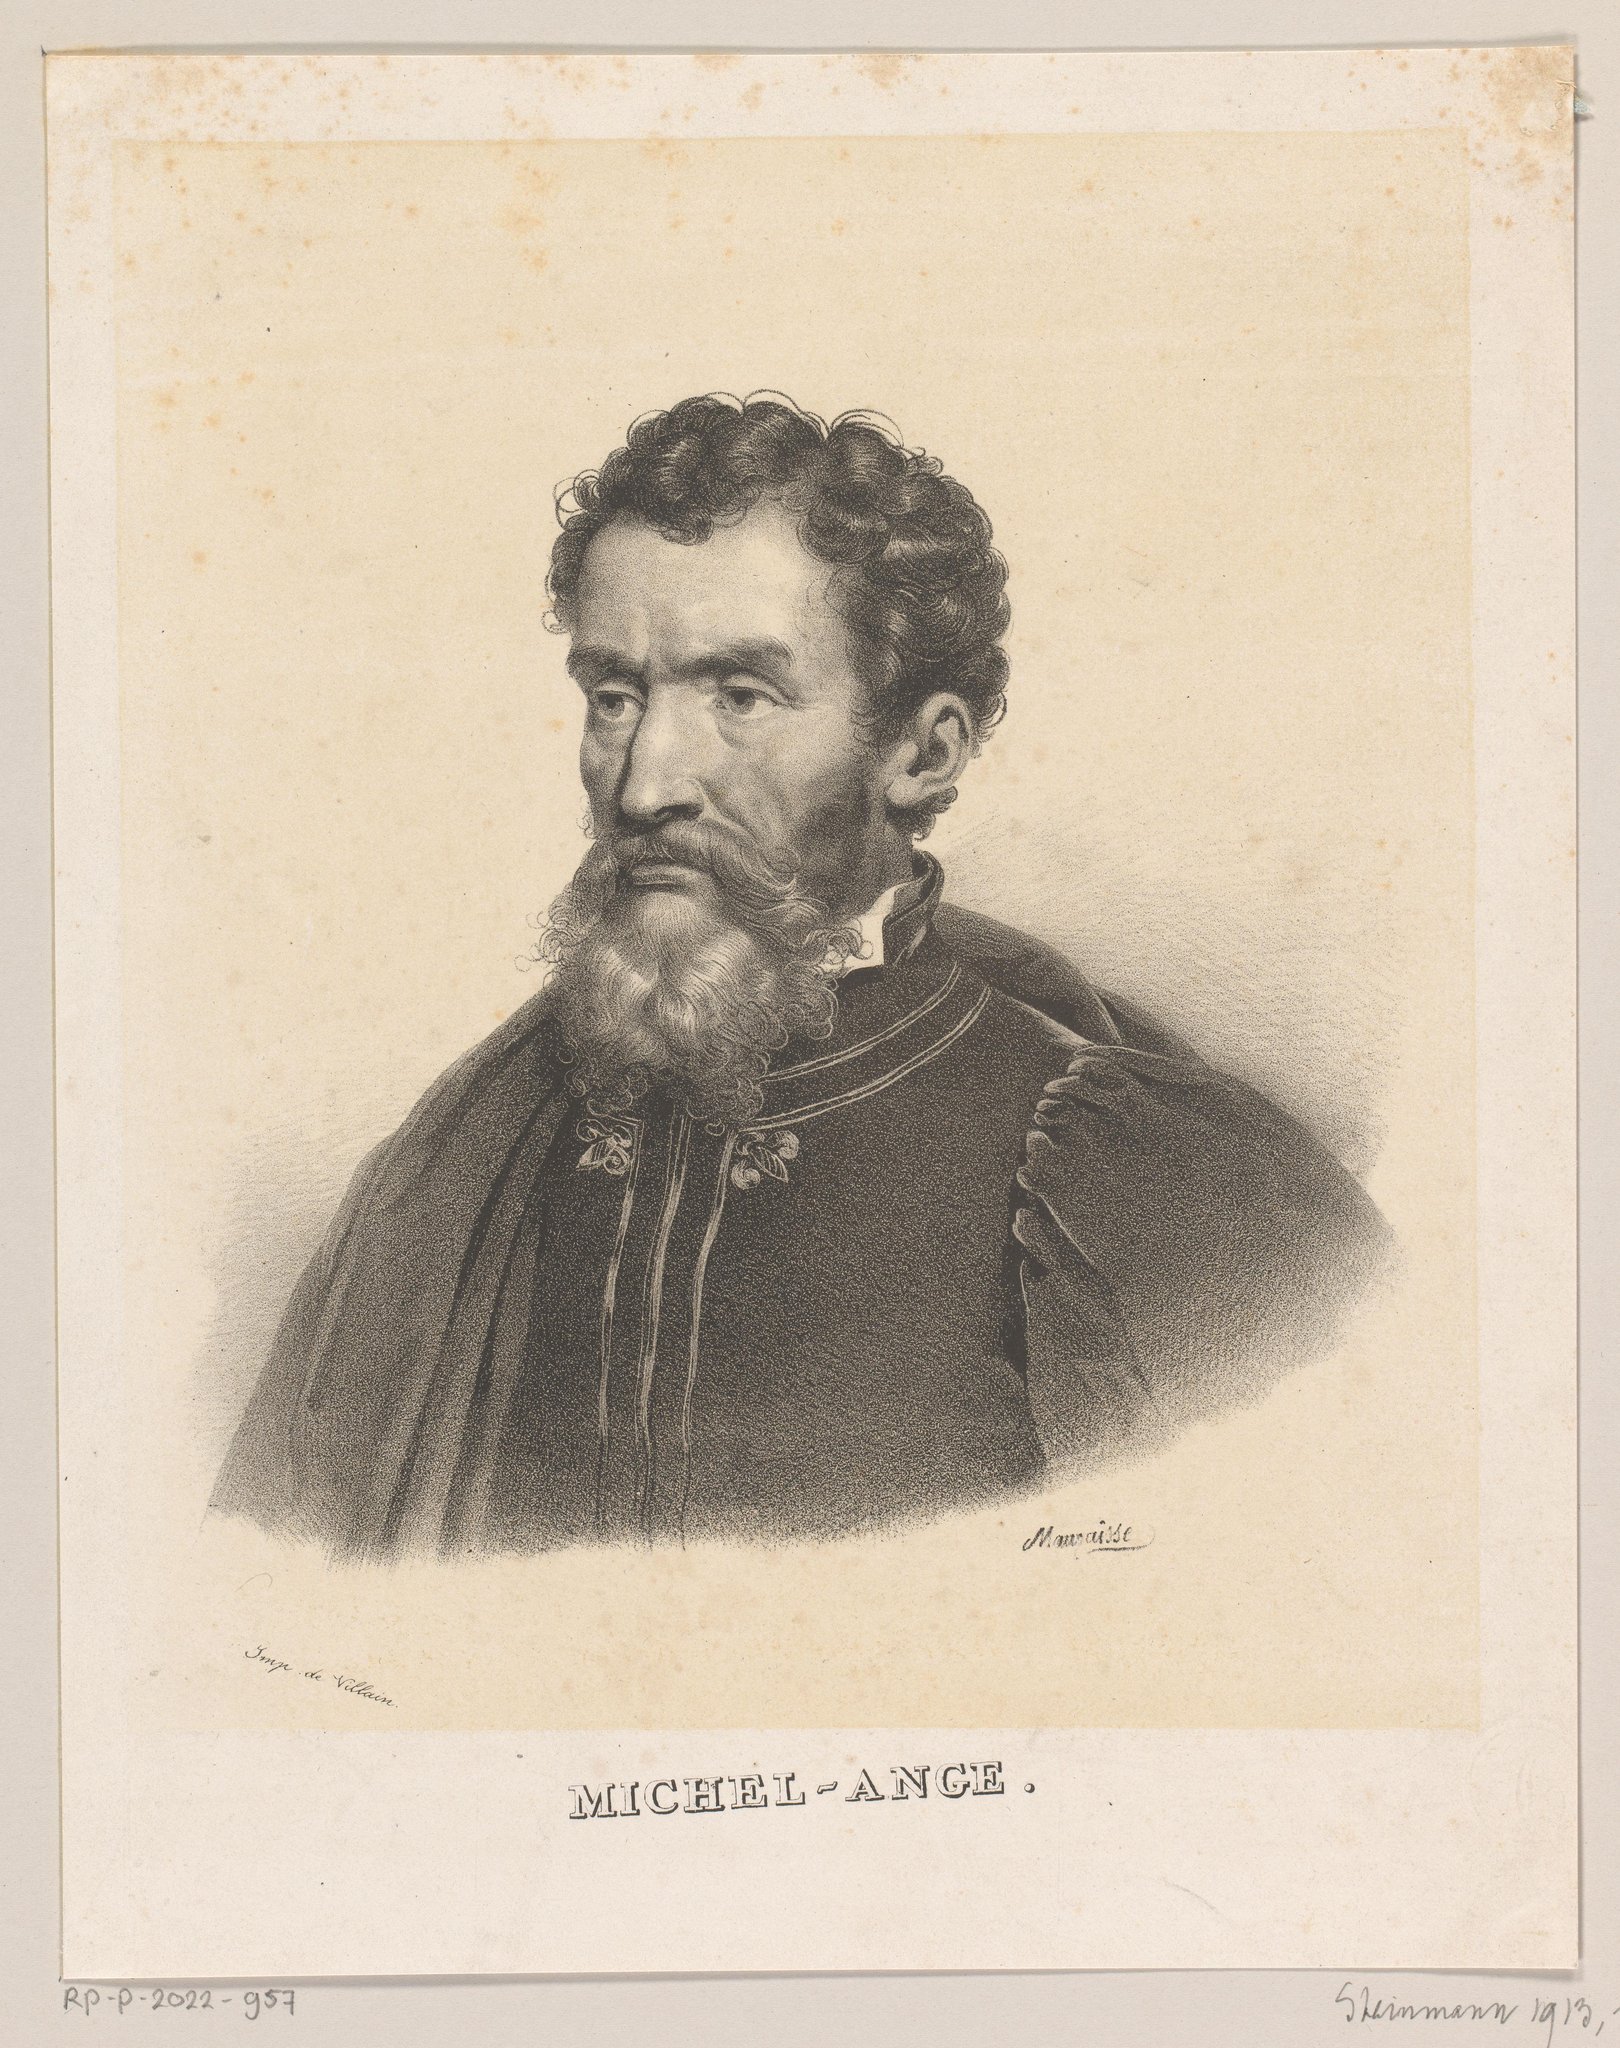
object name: print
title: Portret van Michelangelo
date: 1823-1827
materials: paper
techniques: tone lithography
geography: paris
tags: rome, painter, draughtsman, sculptor, michelangelo, historical persons, portrait, self-portrait of artist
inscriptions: check stamp: ‘JC’, collector's mark: Lugt 2228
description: Prent waarschijnlijk ook gebruikt in: Chabert, Jean Claude. Galerie des peintres ou collection de portraits des peintres les plus célèbres de toutes les écoles. Accompagnée d'une notice sur chacun d'eux, et de copies de dessins originaux / Galerie des peintres ou collection de portraits des peintres les plus célèbres de toutes les écoles. Accompagnée de leur notice historique, de leurs dessins et d'un discours sur les arts. Parijs: Jean Claude Chabert, s.a. [1822-1834]. De samenstelling van tegenwoordig bekende en al dan niet gebonden exemplaren van deze uitgave verschillen. Dit omdat de prenten en bijhorende stukken tekst op inschrijving en waarschijnlijk ook los verkrijgbaar waren.